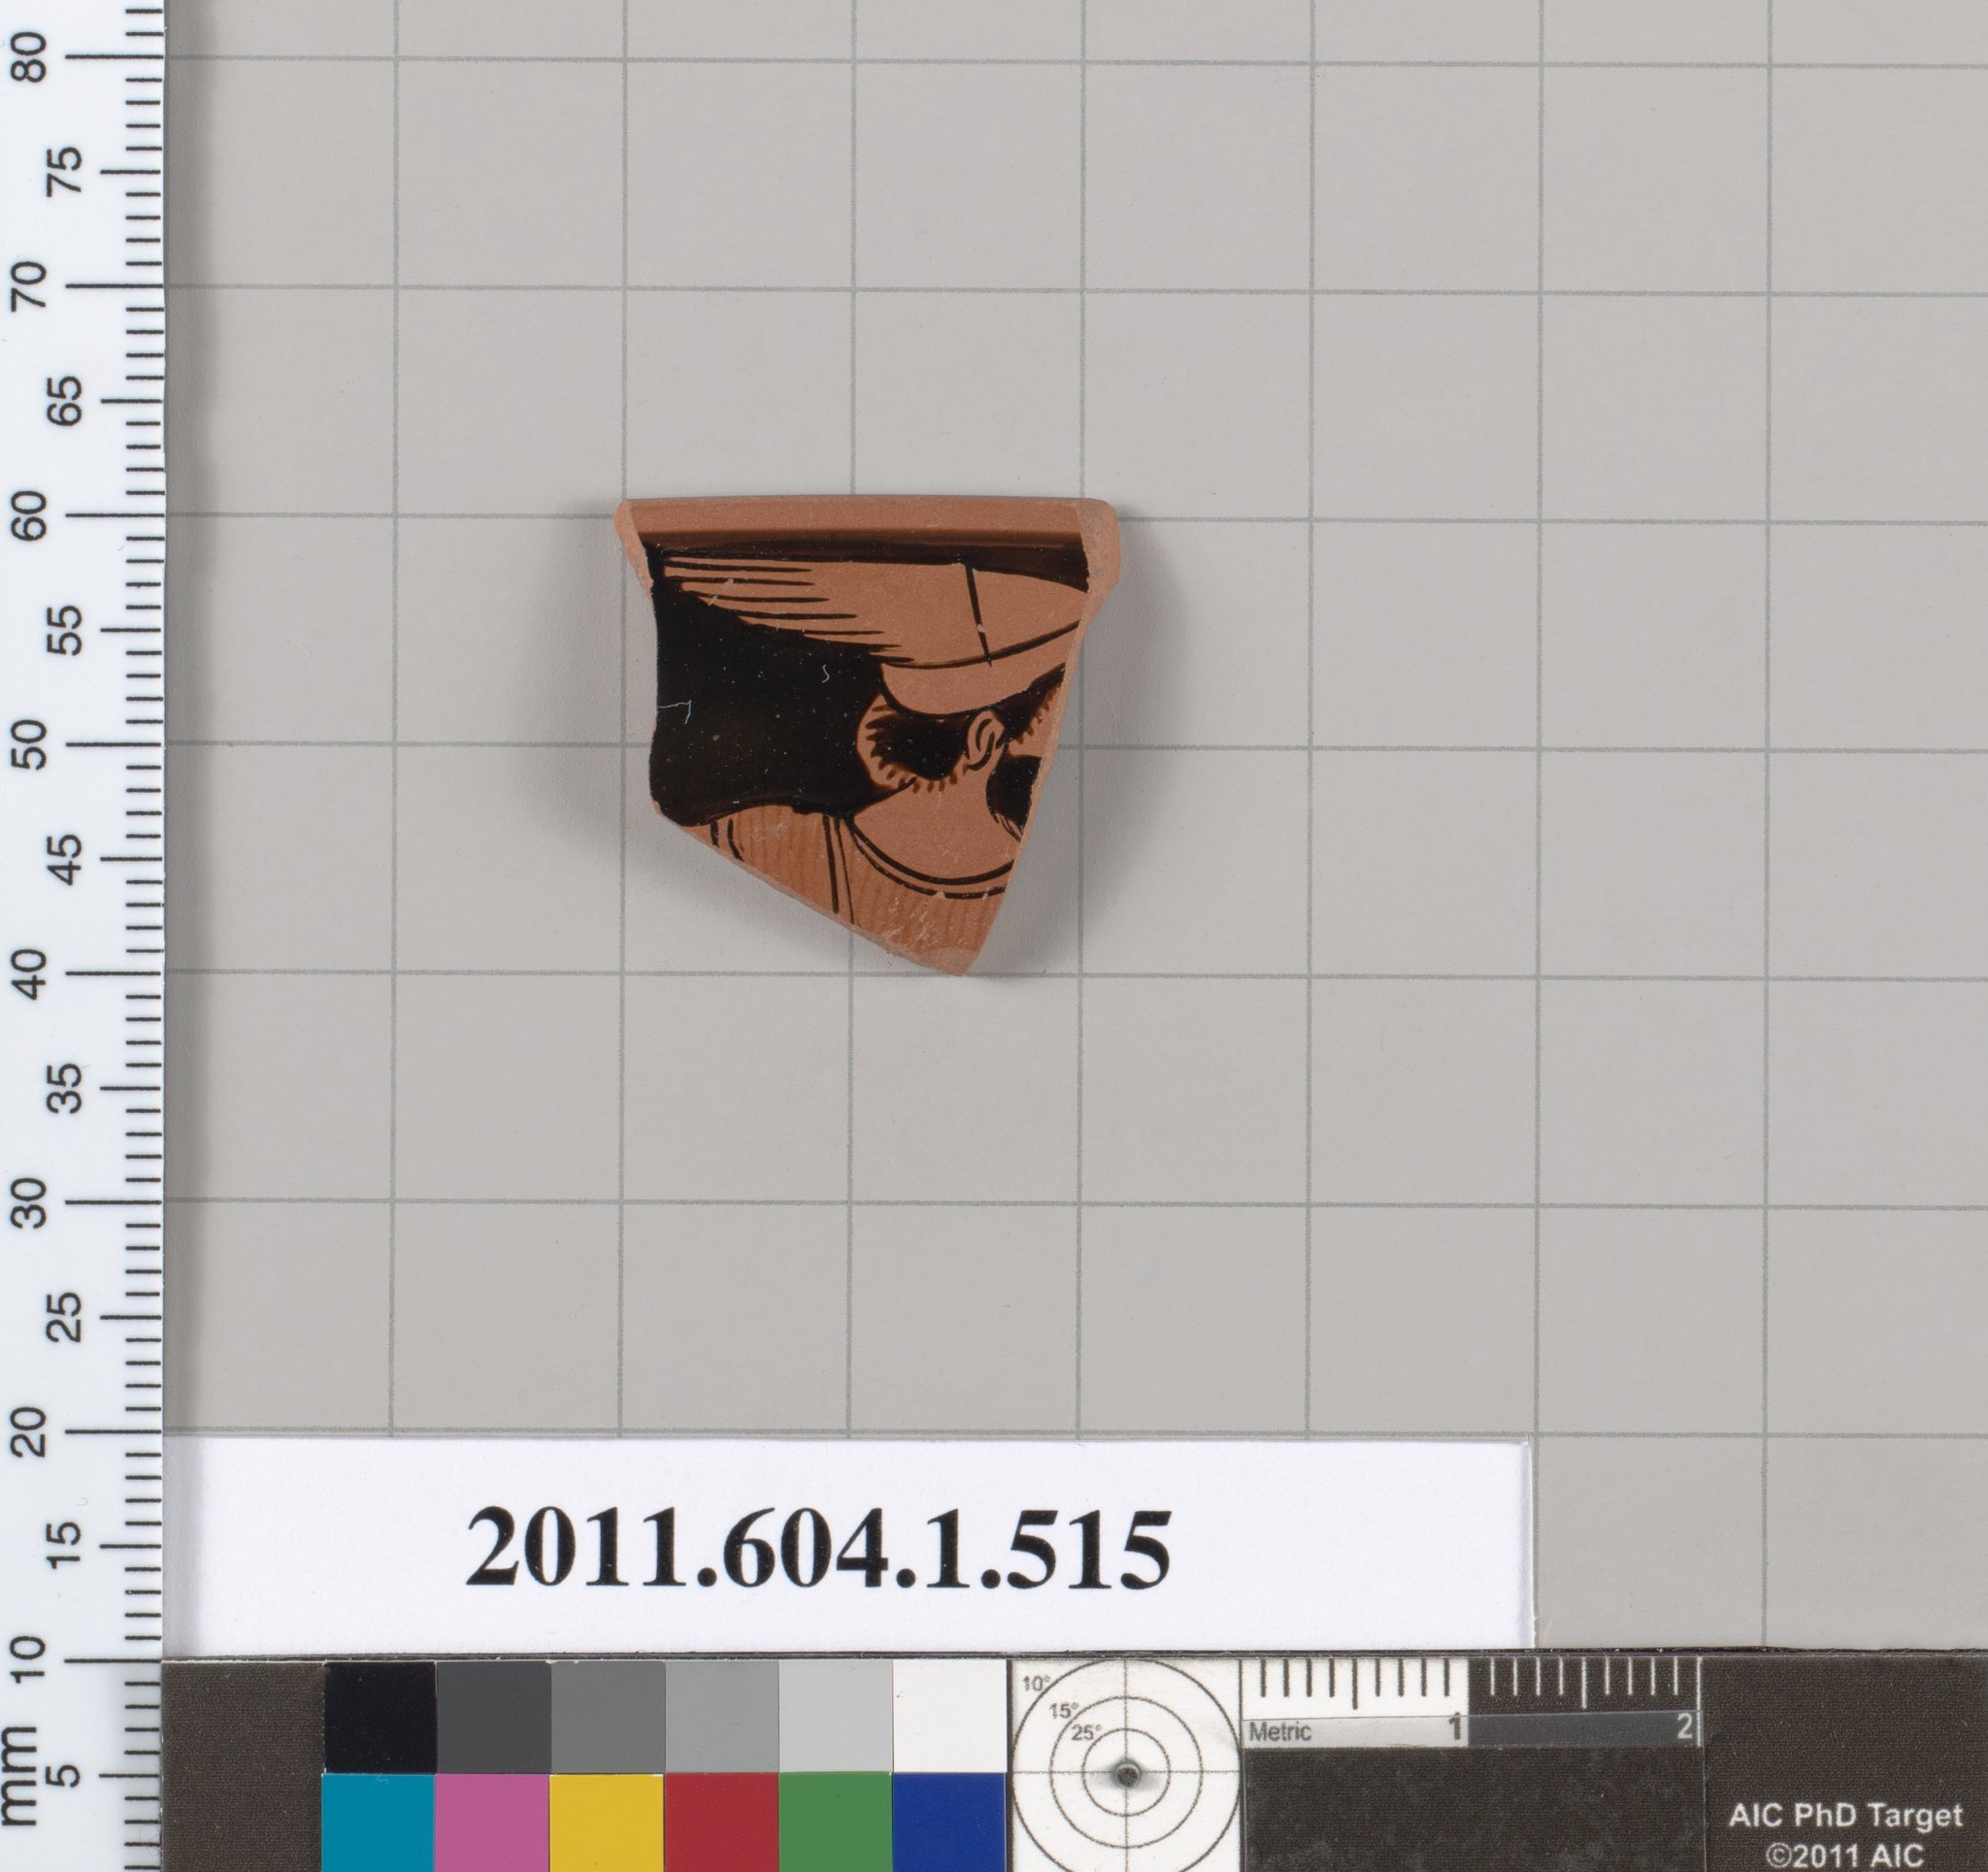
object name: kylix fragment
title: Terracotta rim fragment of a kylix (drinking cup)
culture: greek, attic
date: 490-480 BCE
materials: terracotta